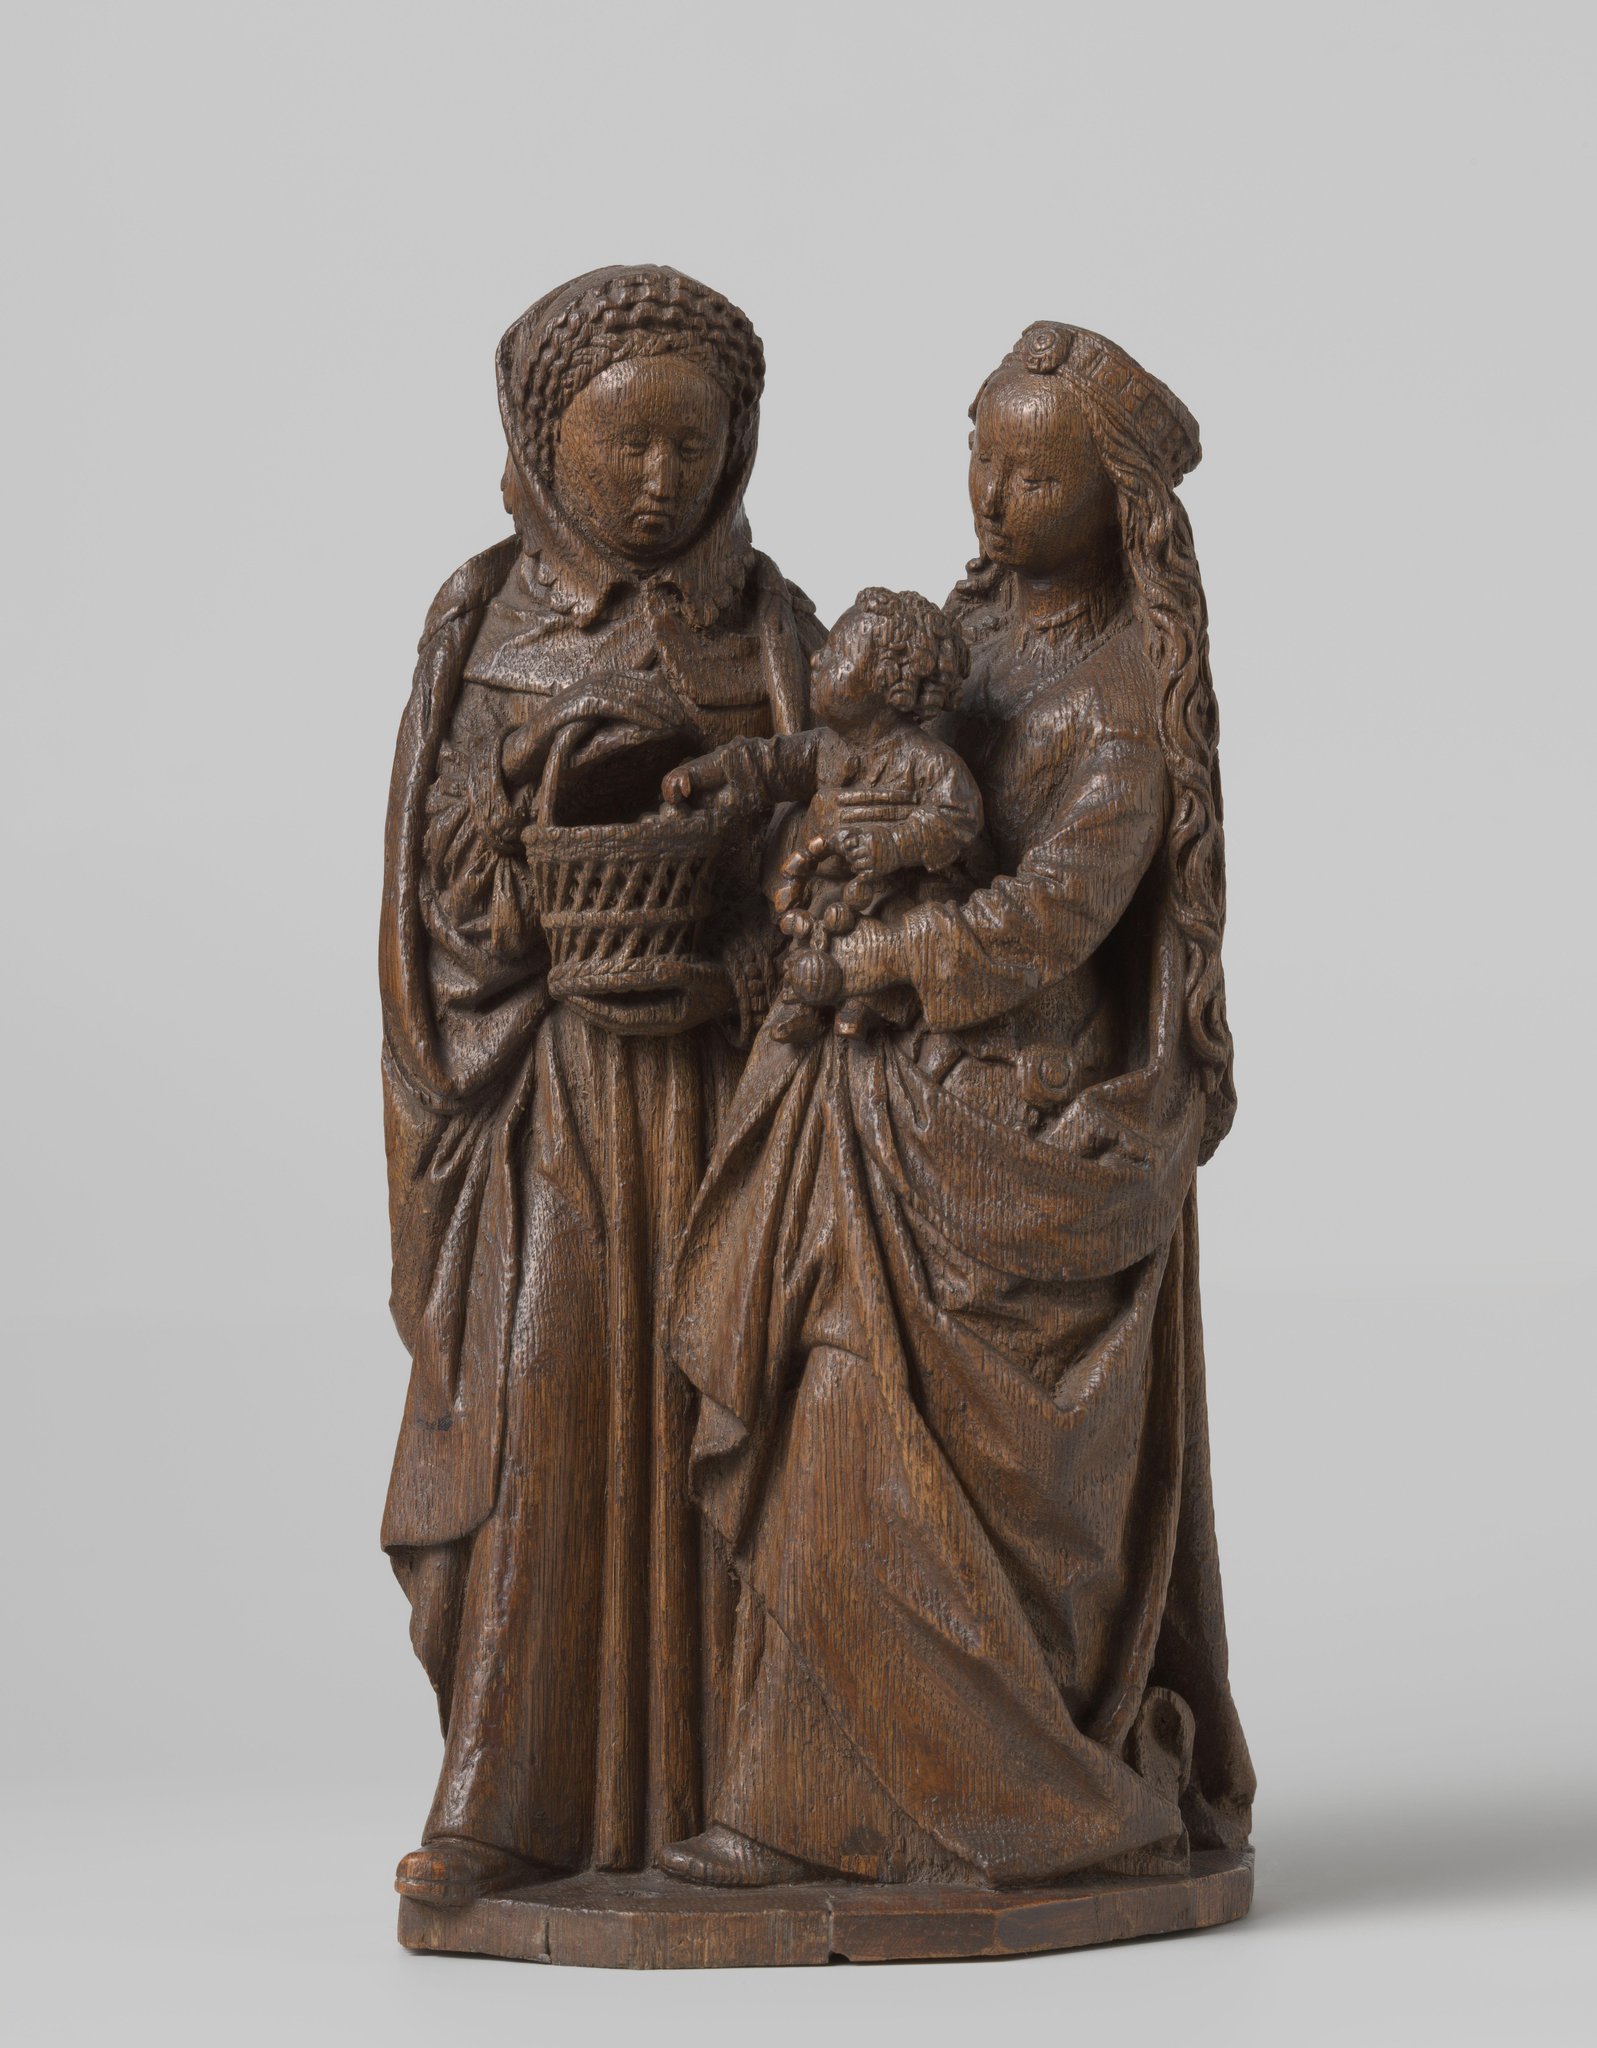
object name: sculpture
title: The Virgin and Child with St Anne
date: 1500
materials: wood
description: Master of Joachim and Anne (active c. 1450 - c. 1490). The Virgin and Child with St Anne. Oak. Holland or Brabant, c. 1470.